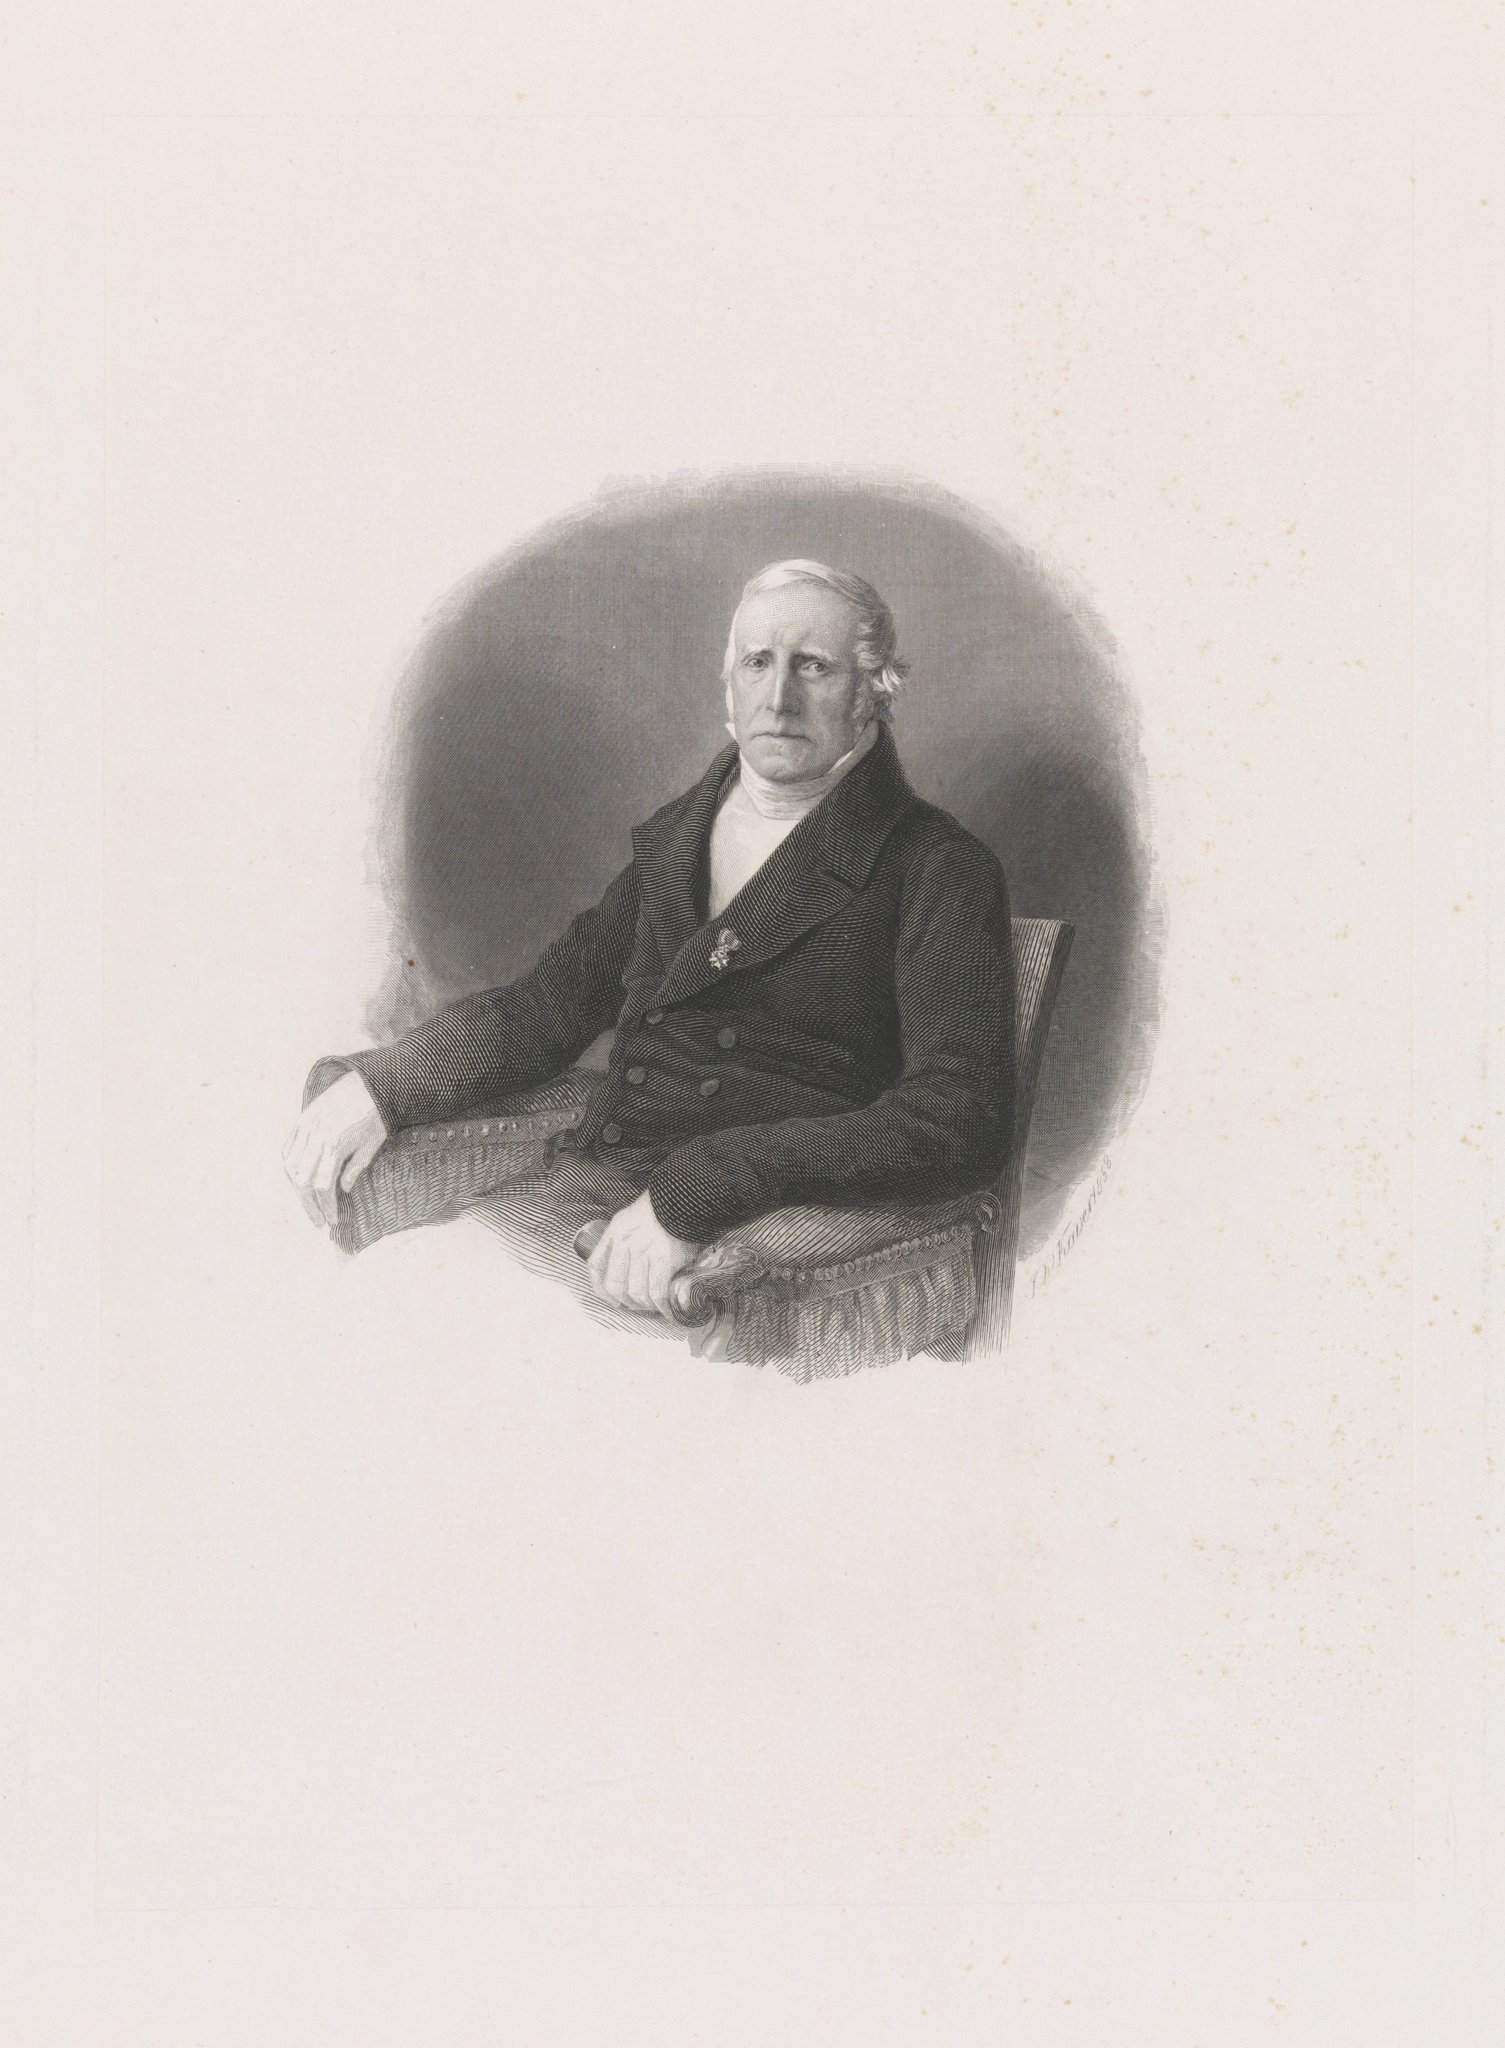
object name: print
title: Portret van Willem Hendrik Warnsinck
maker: johann wilhelm kaiser (i)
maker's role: draughtsman, print maker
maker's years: 1813-1900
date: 1858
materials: paper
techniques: etching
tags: amsterdam, willem hendrik warnsinck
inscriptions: inscription: ‘W.H. Warnsinck oude Heer Warnsink’, collector's mark: Lugt 964, collector's mark: Lugt 2228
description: Portret van de dichter Willem Hendrik Warnsinck, ten halven lijve.